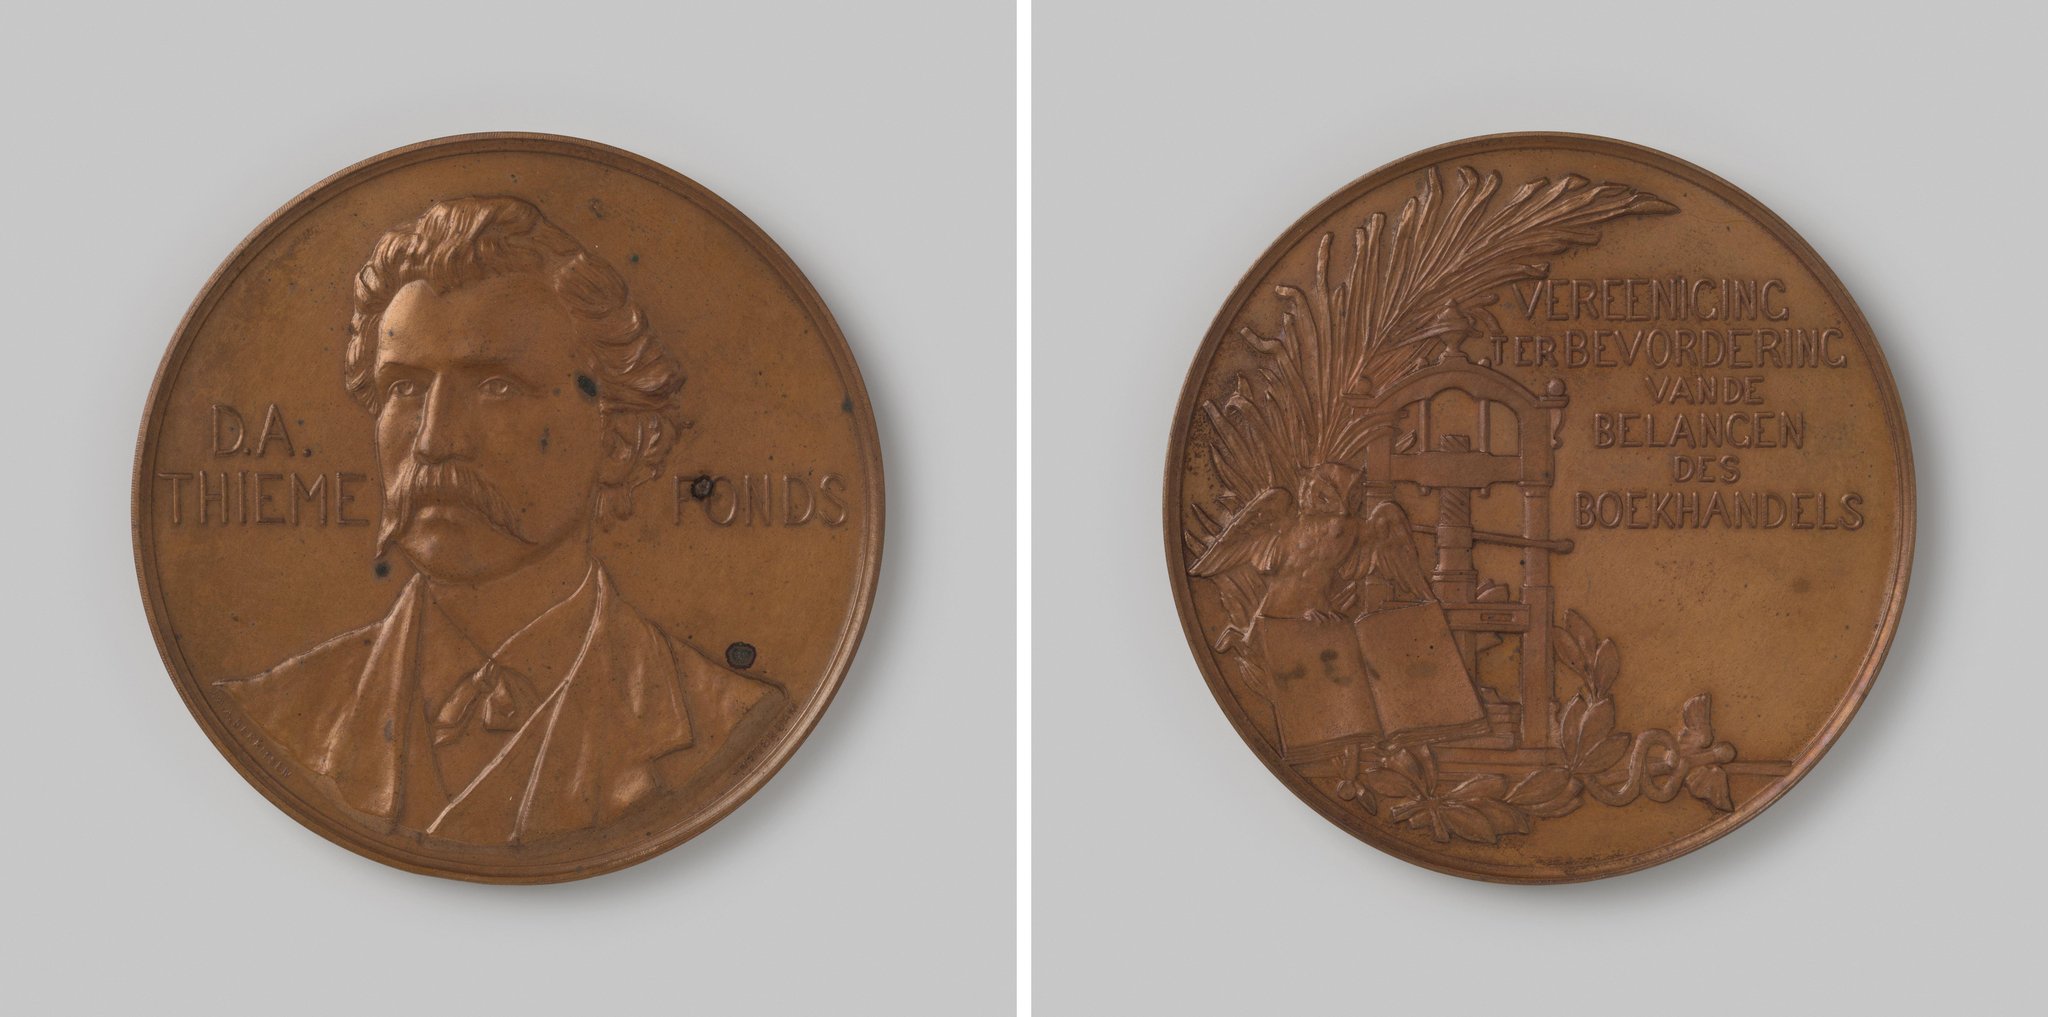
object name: history medal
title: Prijspenning van het D.A. Thieme Fonds van de Vereeniging ter Bevordering van de Belangen des Boekhandels, 1900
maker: j.a.a. gerritsen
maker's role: manufacturer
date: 1900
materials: bronze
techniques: striking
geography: amsterdam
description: Bronzen penning, op de voorzijde het bijna aanziende borstbeeld van Dirk Anthonie Thieme met links en rechts opschrift, op de keerzijde zes regels tekst met links een palmtak, drukpers, boek, uil, mercuriusstaf en lauwerkrans.